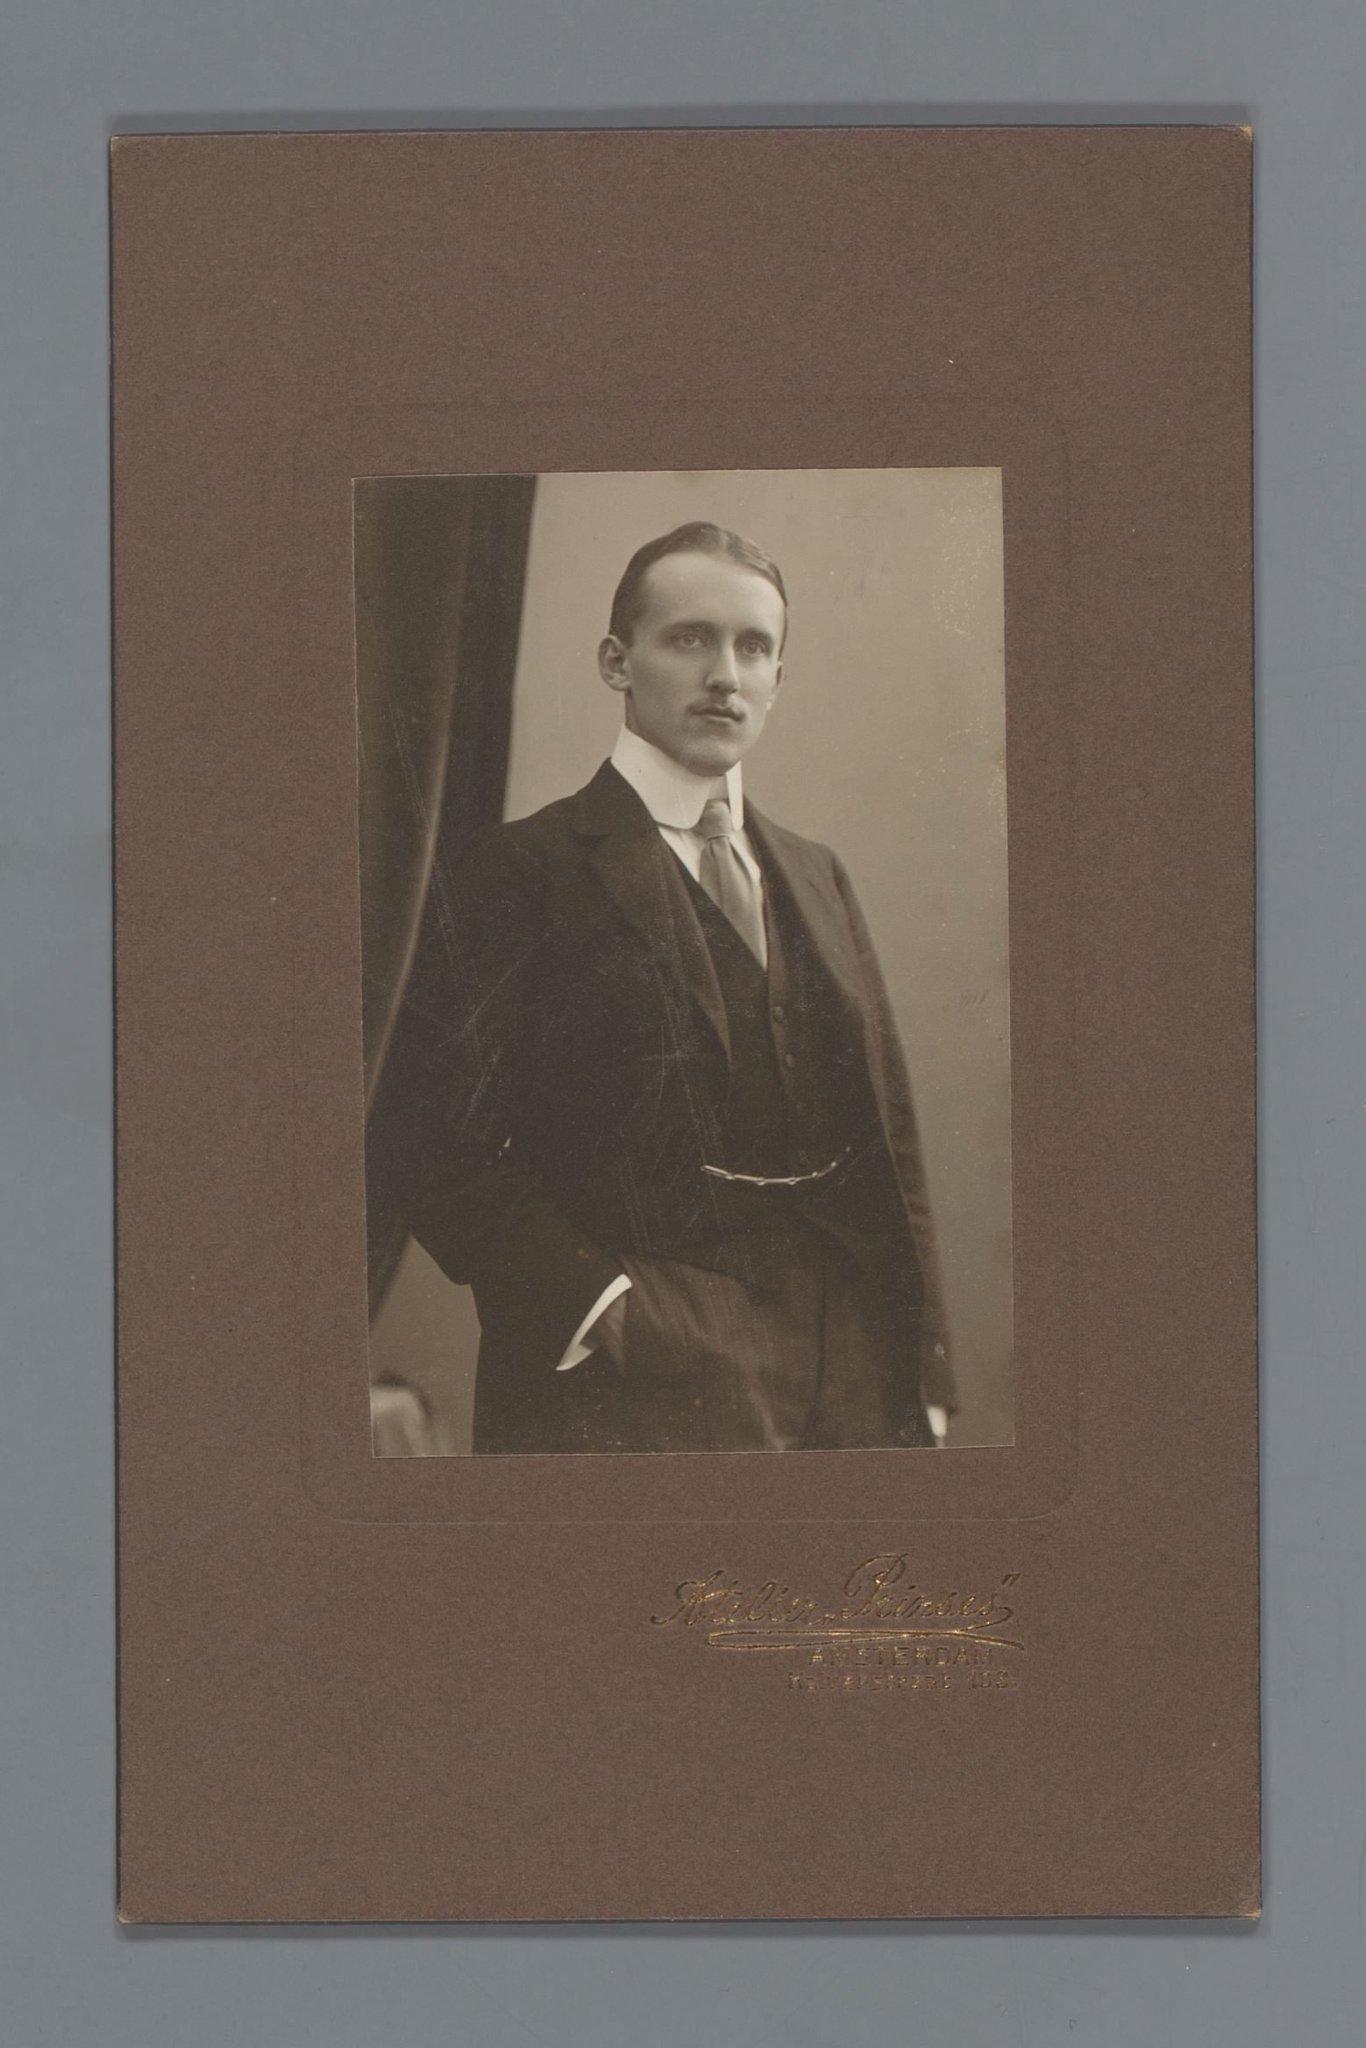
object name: photograph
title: Studioportret van een onbekende man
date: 1895-1910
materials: cardboard, photographic support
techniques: gelatin silver print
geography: amsterdam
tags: adult man